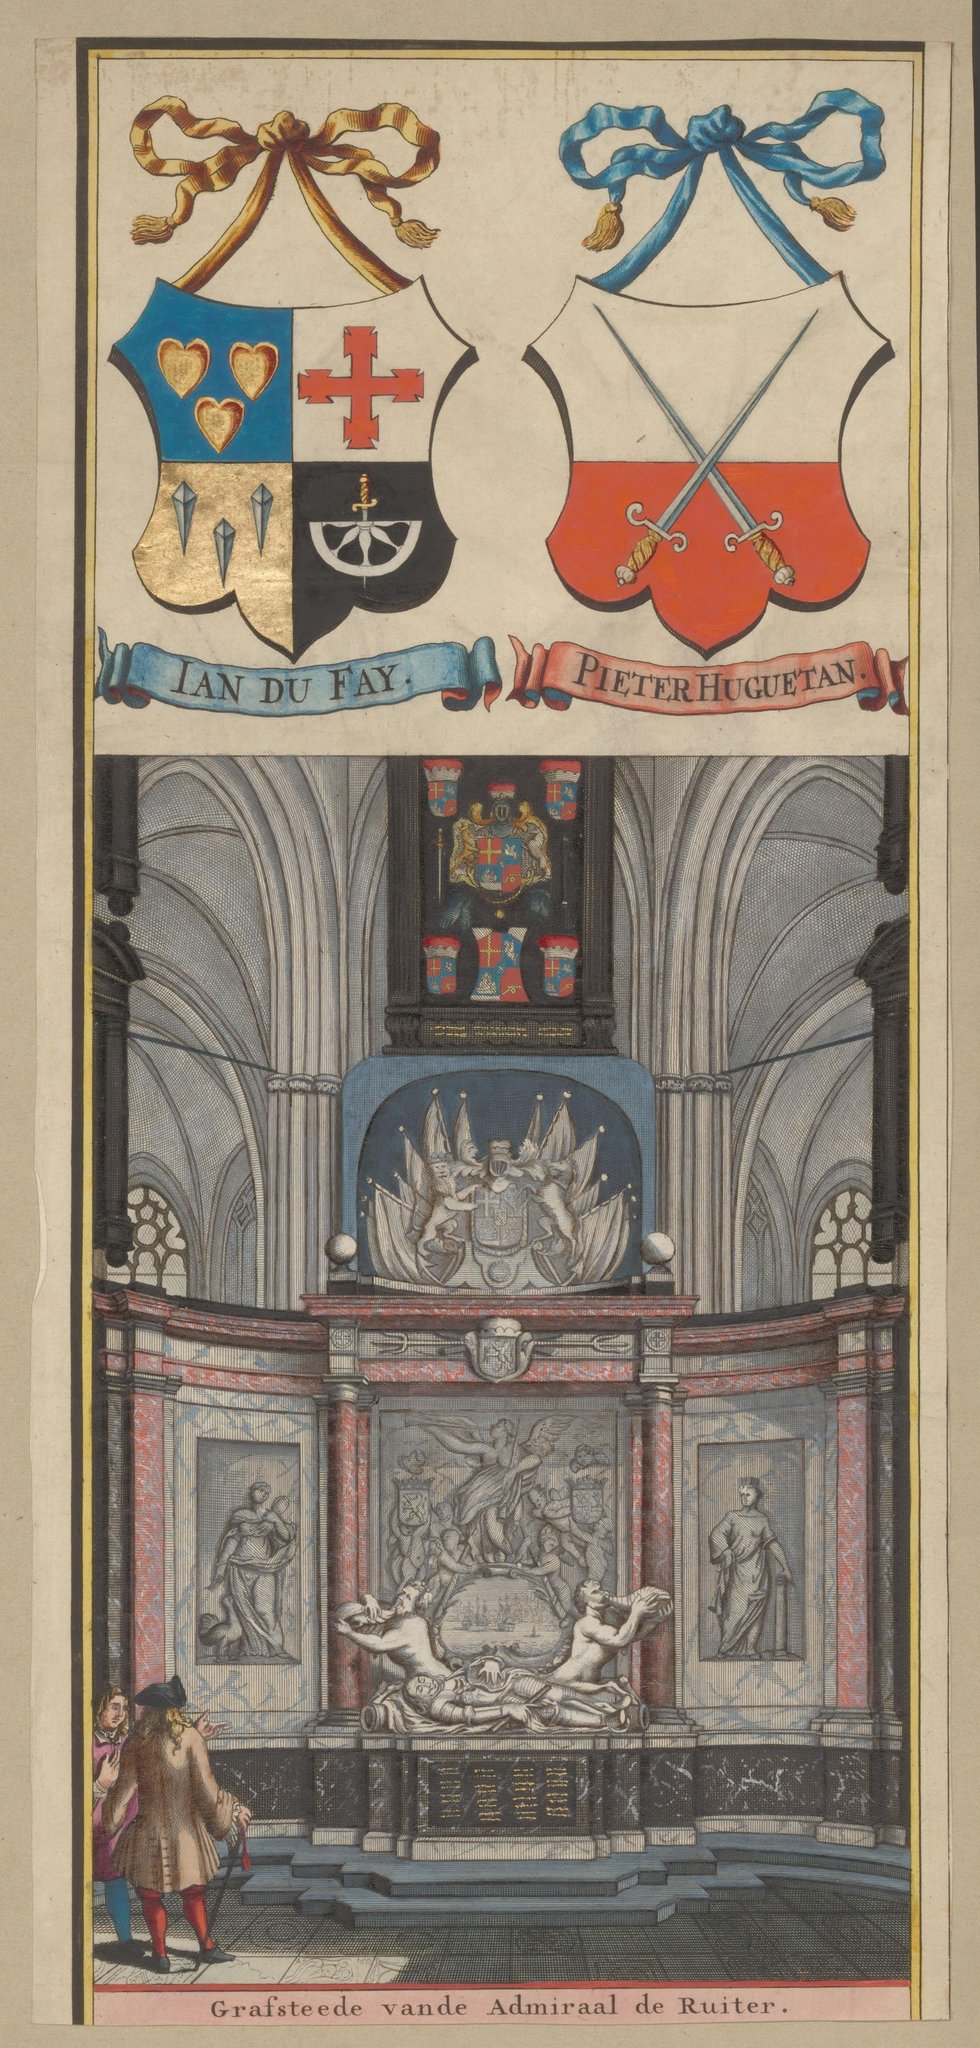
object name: print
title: Twee wapens van kerkmeesters van de Nieuwe Kerk te Amsterdam en grafmonument van Michiel de Ruyter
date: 1719-1721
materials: gouache, ink, paper, watercolor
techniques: engraving, etching, hand coloring, pen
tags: michiel adriaenszoon de ruyter, grave-building, monumental tomb, armorial bearing, heraldry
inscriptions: collector's mark: Lugt 1641b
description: Datering op basis van periode waarin Jan Noach du Fay (tot 1721) en Pierre Huguetan (minstens tot 1731) allebei in Amsterdam verbleven enerzijds en stilistische overeenkomsten met KOG-AA-1-30-72A anderzijds. Dat object kan gedateerd worden op basis van periode waarin Matthias van Hartoghveld (1714-1724) en Paulus Emtinck (1719-1727) allebei kerkmeester van de Nieuwe Kerk te Amsterdam waren. Hieruit komt voor beide objecten een datering tussen 1719 en 1721 voort.